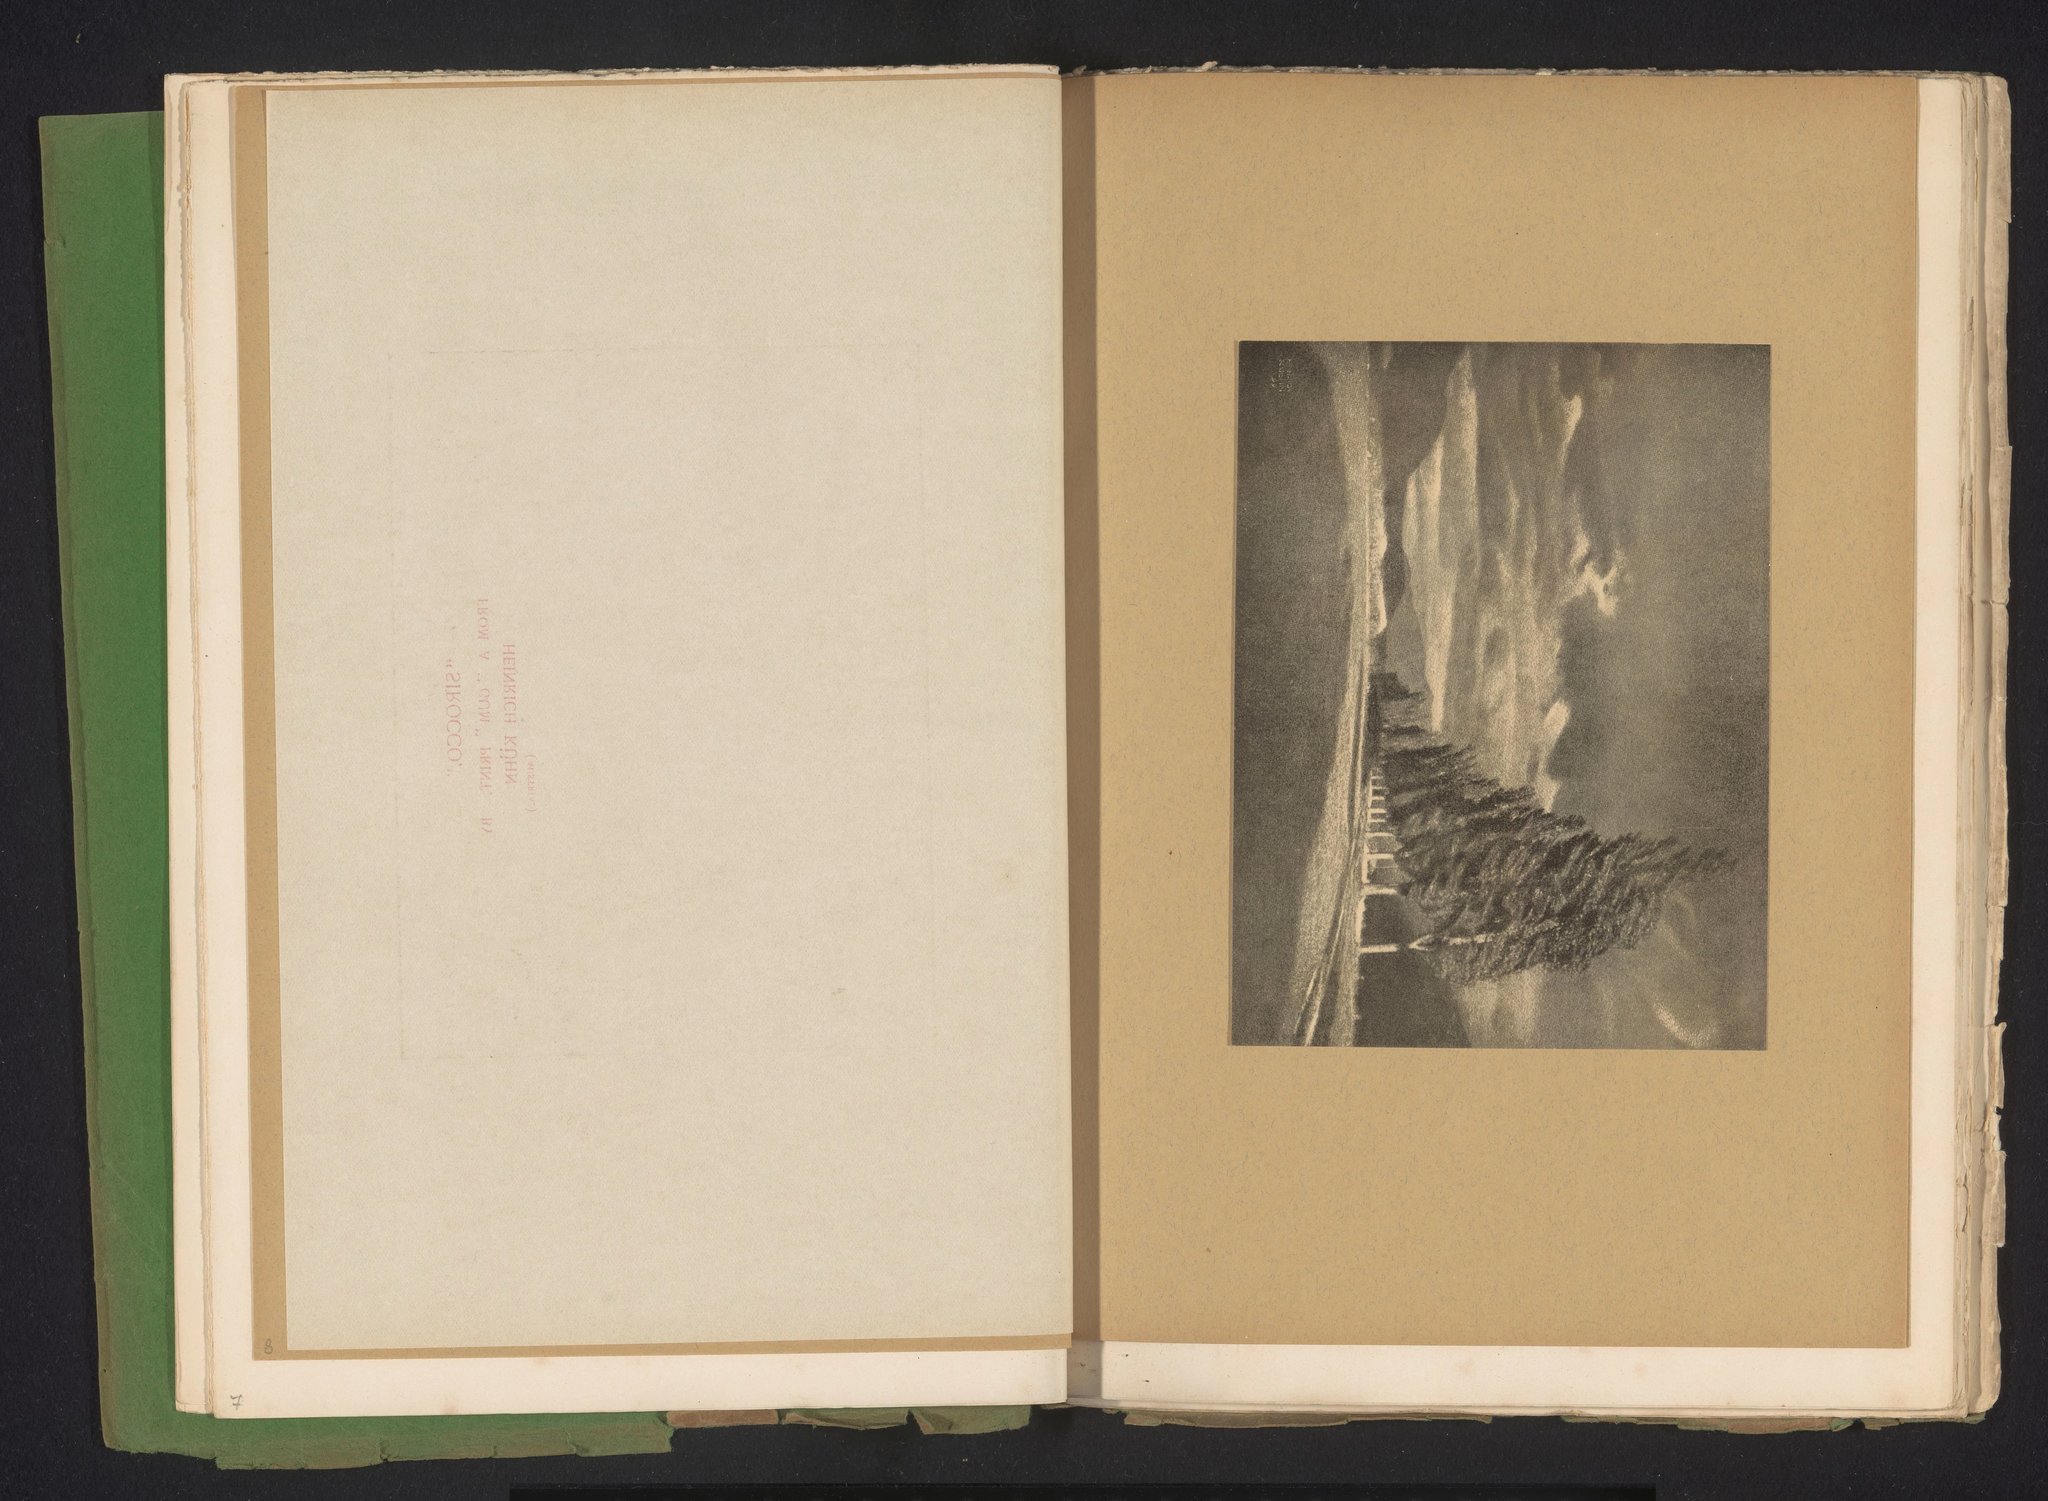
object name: page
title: Landschap met bomen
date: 1897-1902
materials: paper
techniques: autotype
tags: trees, landscapes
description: Prent op derde ongenummerde pagina na pagina 250, achter semi-transparante omslag.